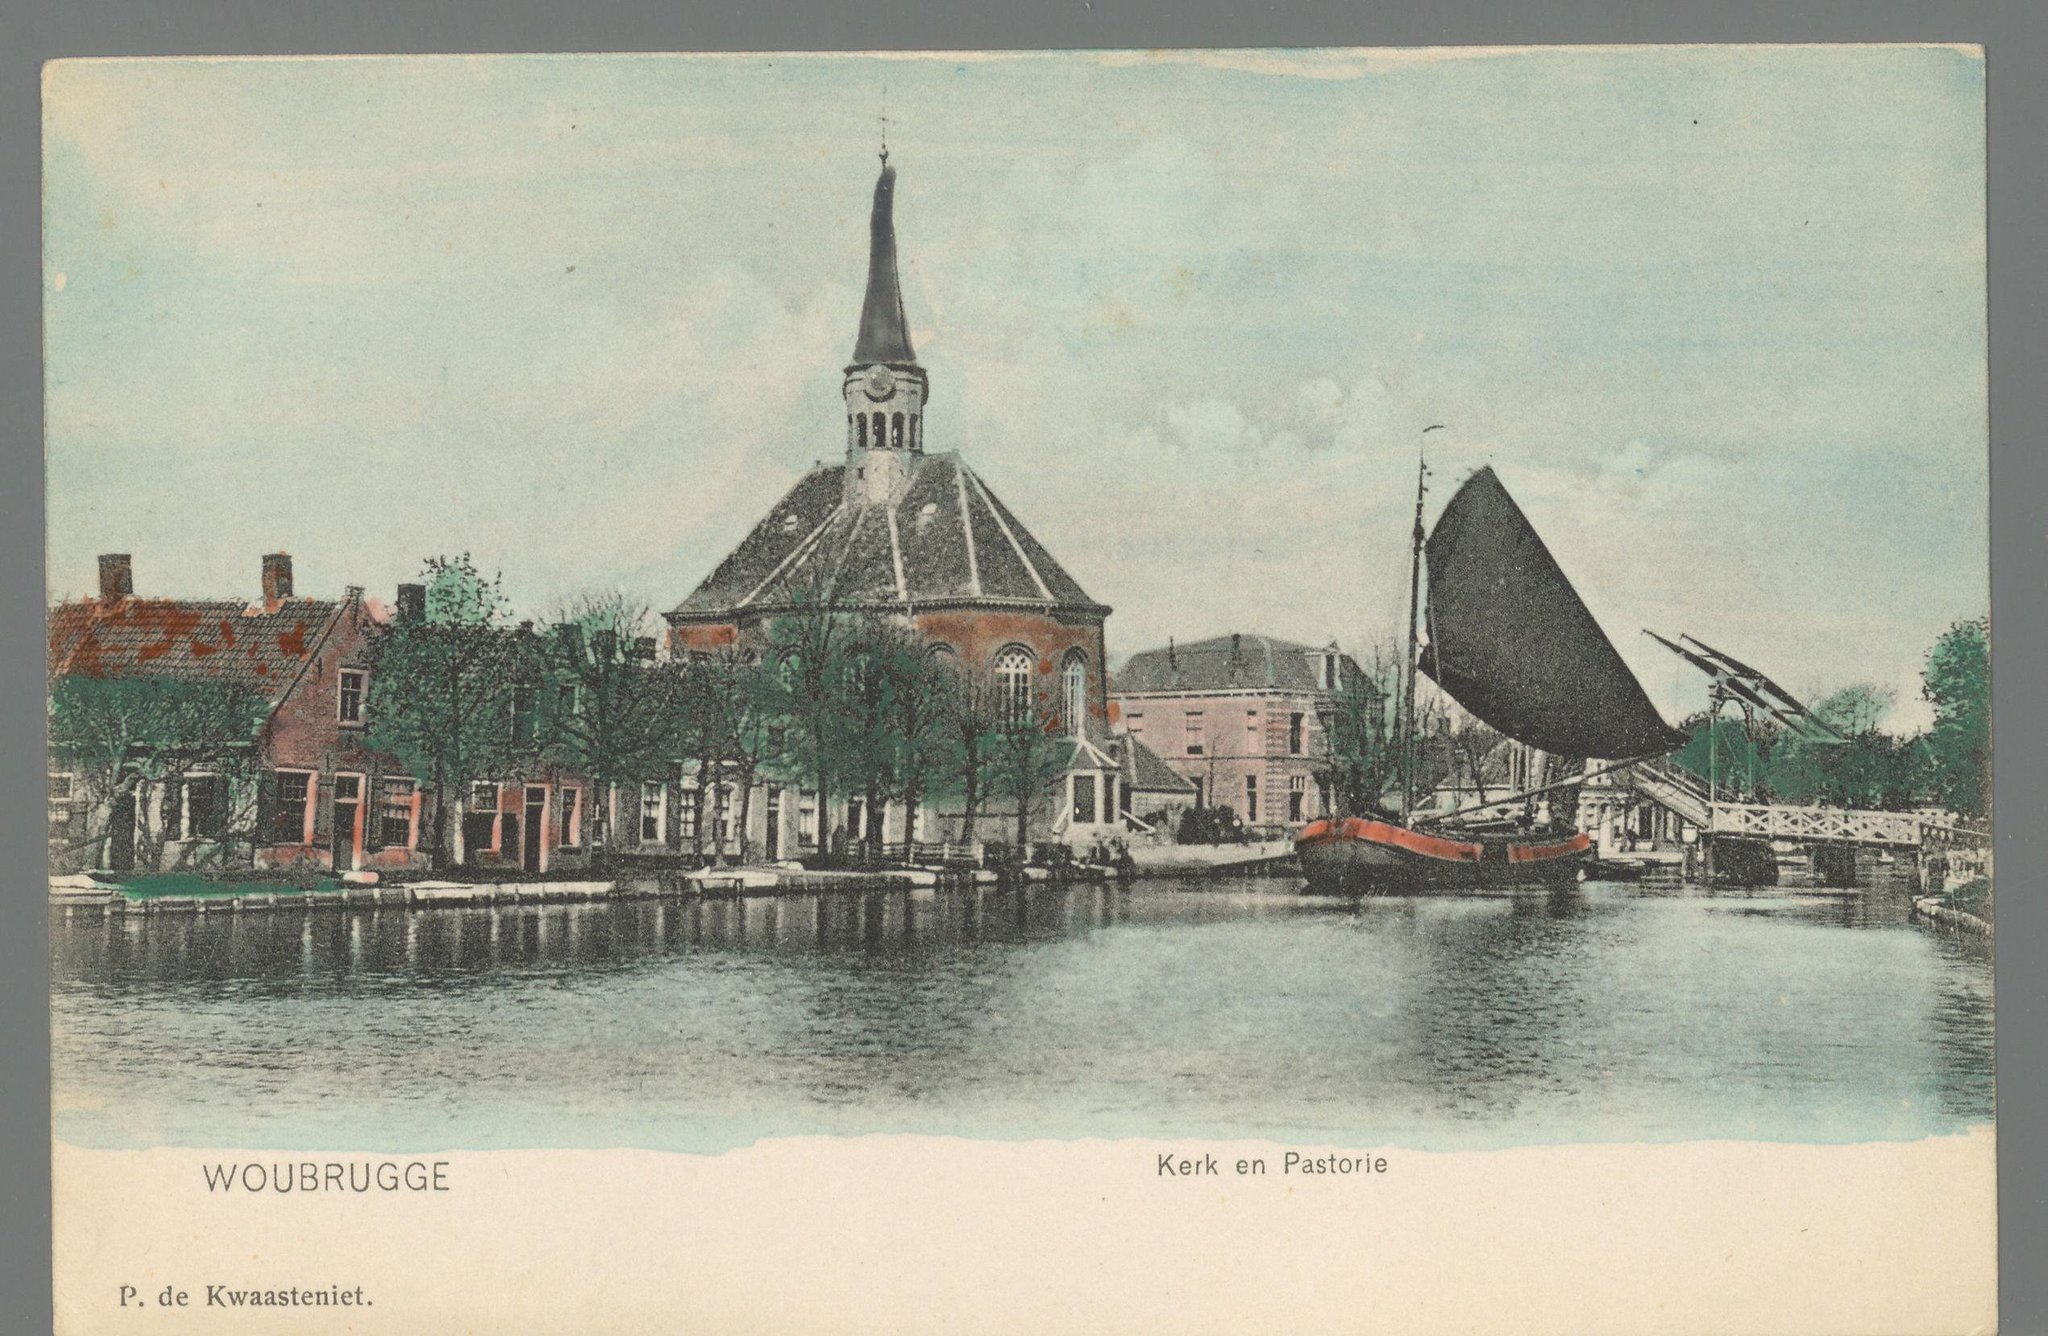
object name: ansichtkaart, prentbriefkaart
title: Woubrugge. Kerk en pastorie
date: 1897-1905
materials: cardboard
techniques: photograph, hand coloring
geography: woubrugge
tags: city-view, and landscape with man-made constructions, canals, waters (in village), church (exterior), bridge in village across river, canal, etc.